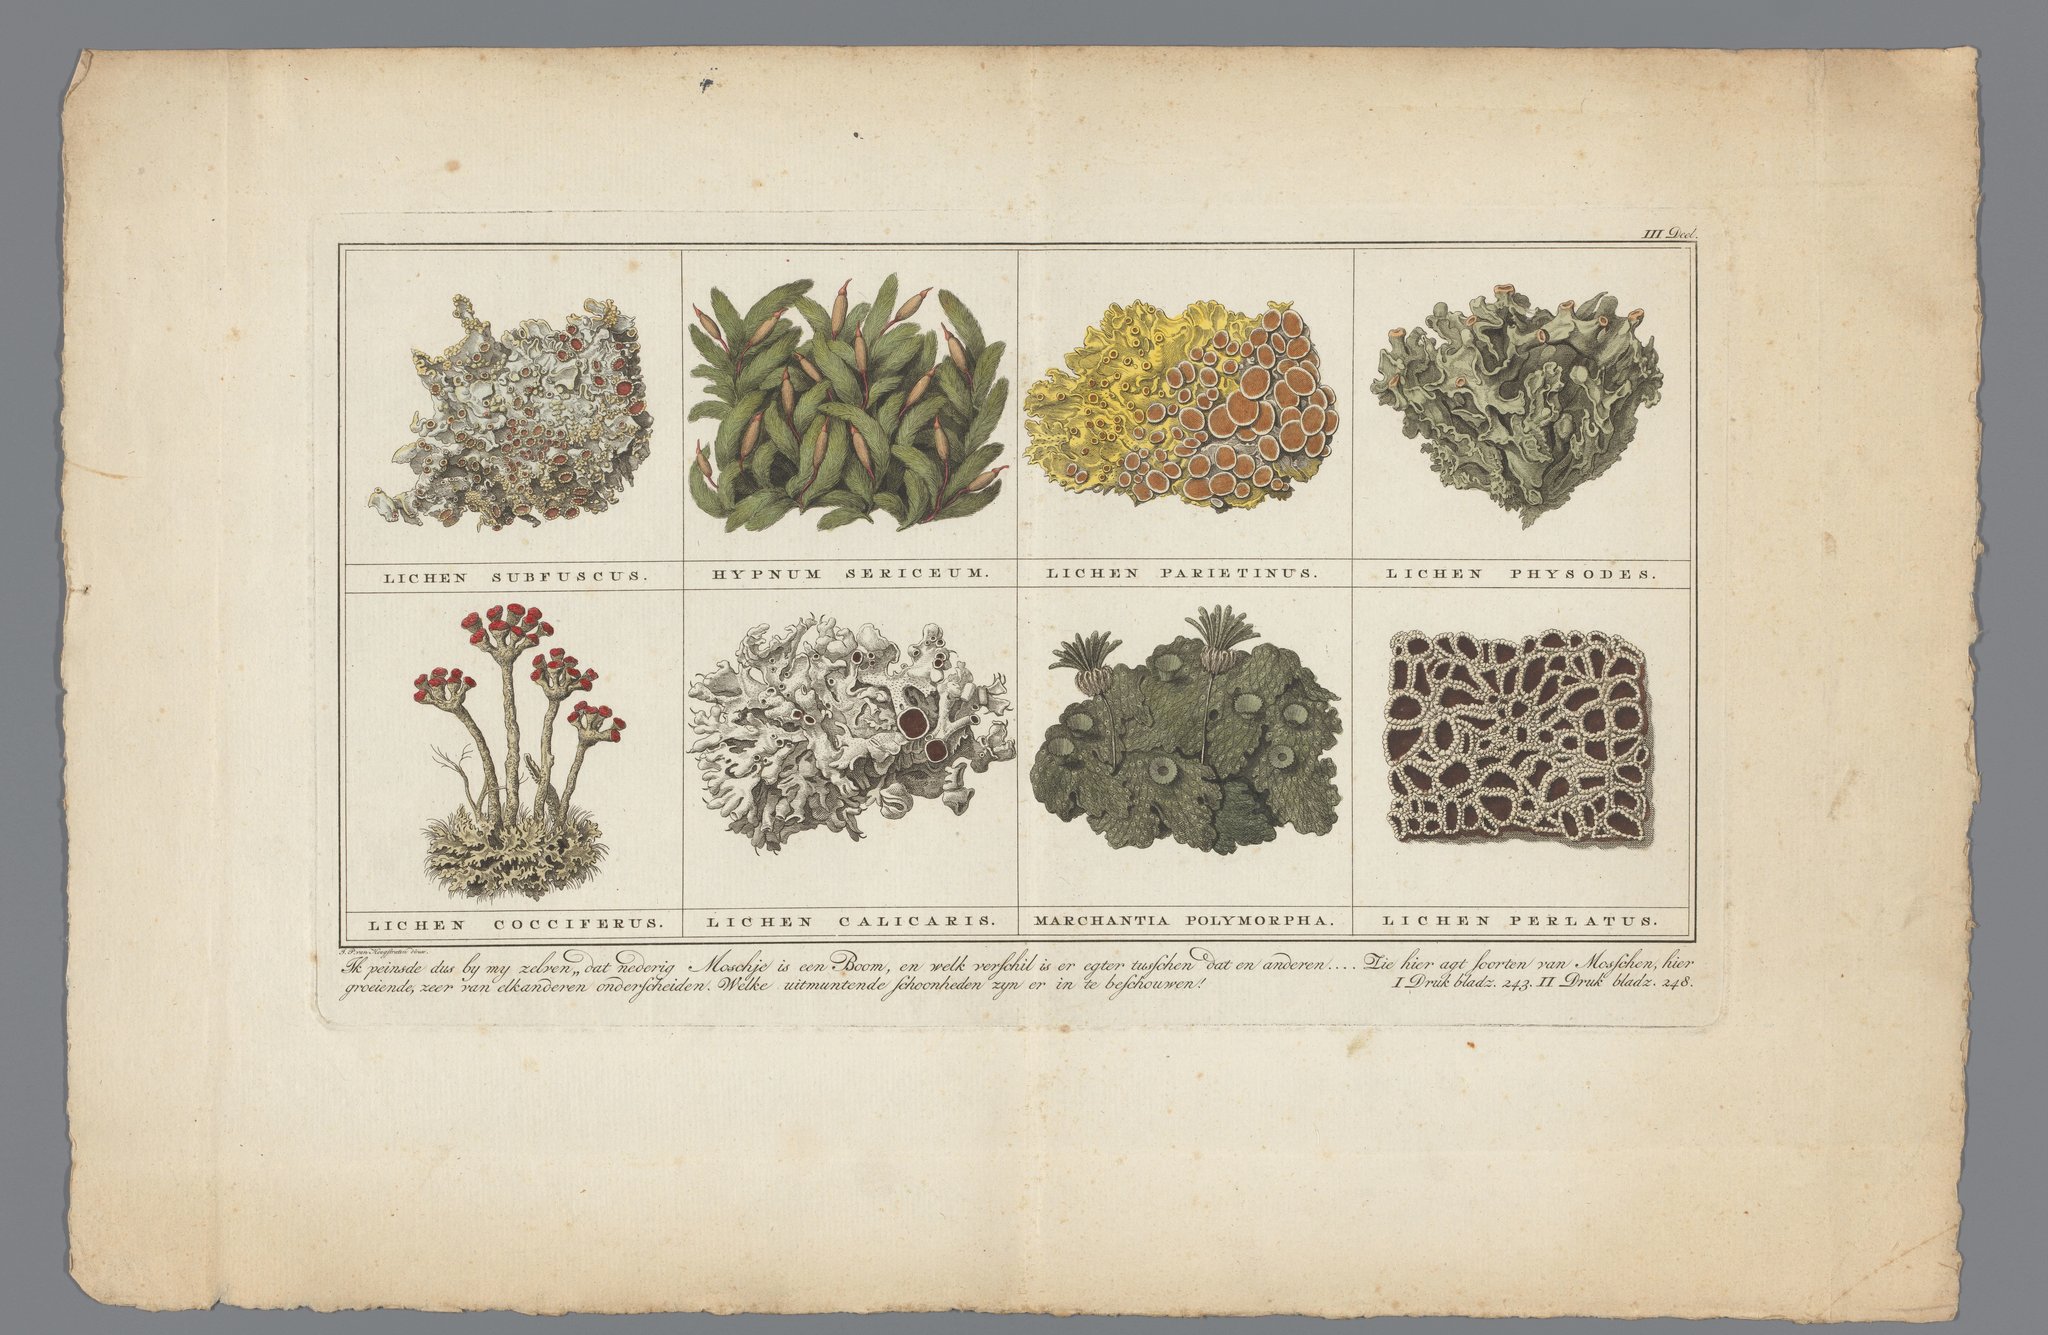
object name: print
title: Acht soorten mossen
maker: j.p. van hoogstraten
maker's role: publisher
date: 1779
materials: paper, watercolor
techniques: brush, engraving, etching, hand coloring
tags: mosses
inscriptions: collector's mark: Lugt 2228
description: Lichen Subfuscus, Hypnum Sericeum, Lichen Parietinus, Lichen Physodes, Lichen Cocciferus, Lichen Calicaris, Marchantia Polymorpha. Lichen Perlatus.